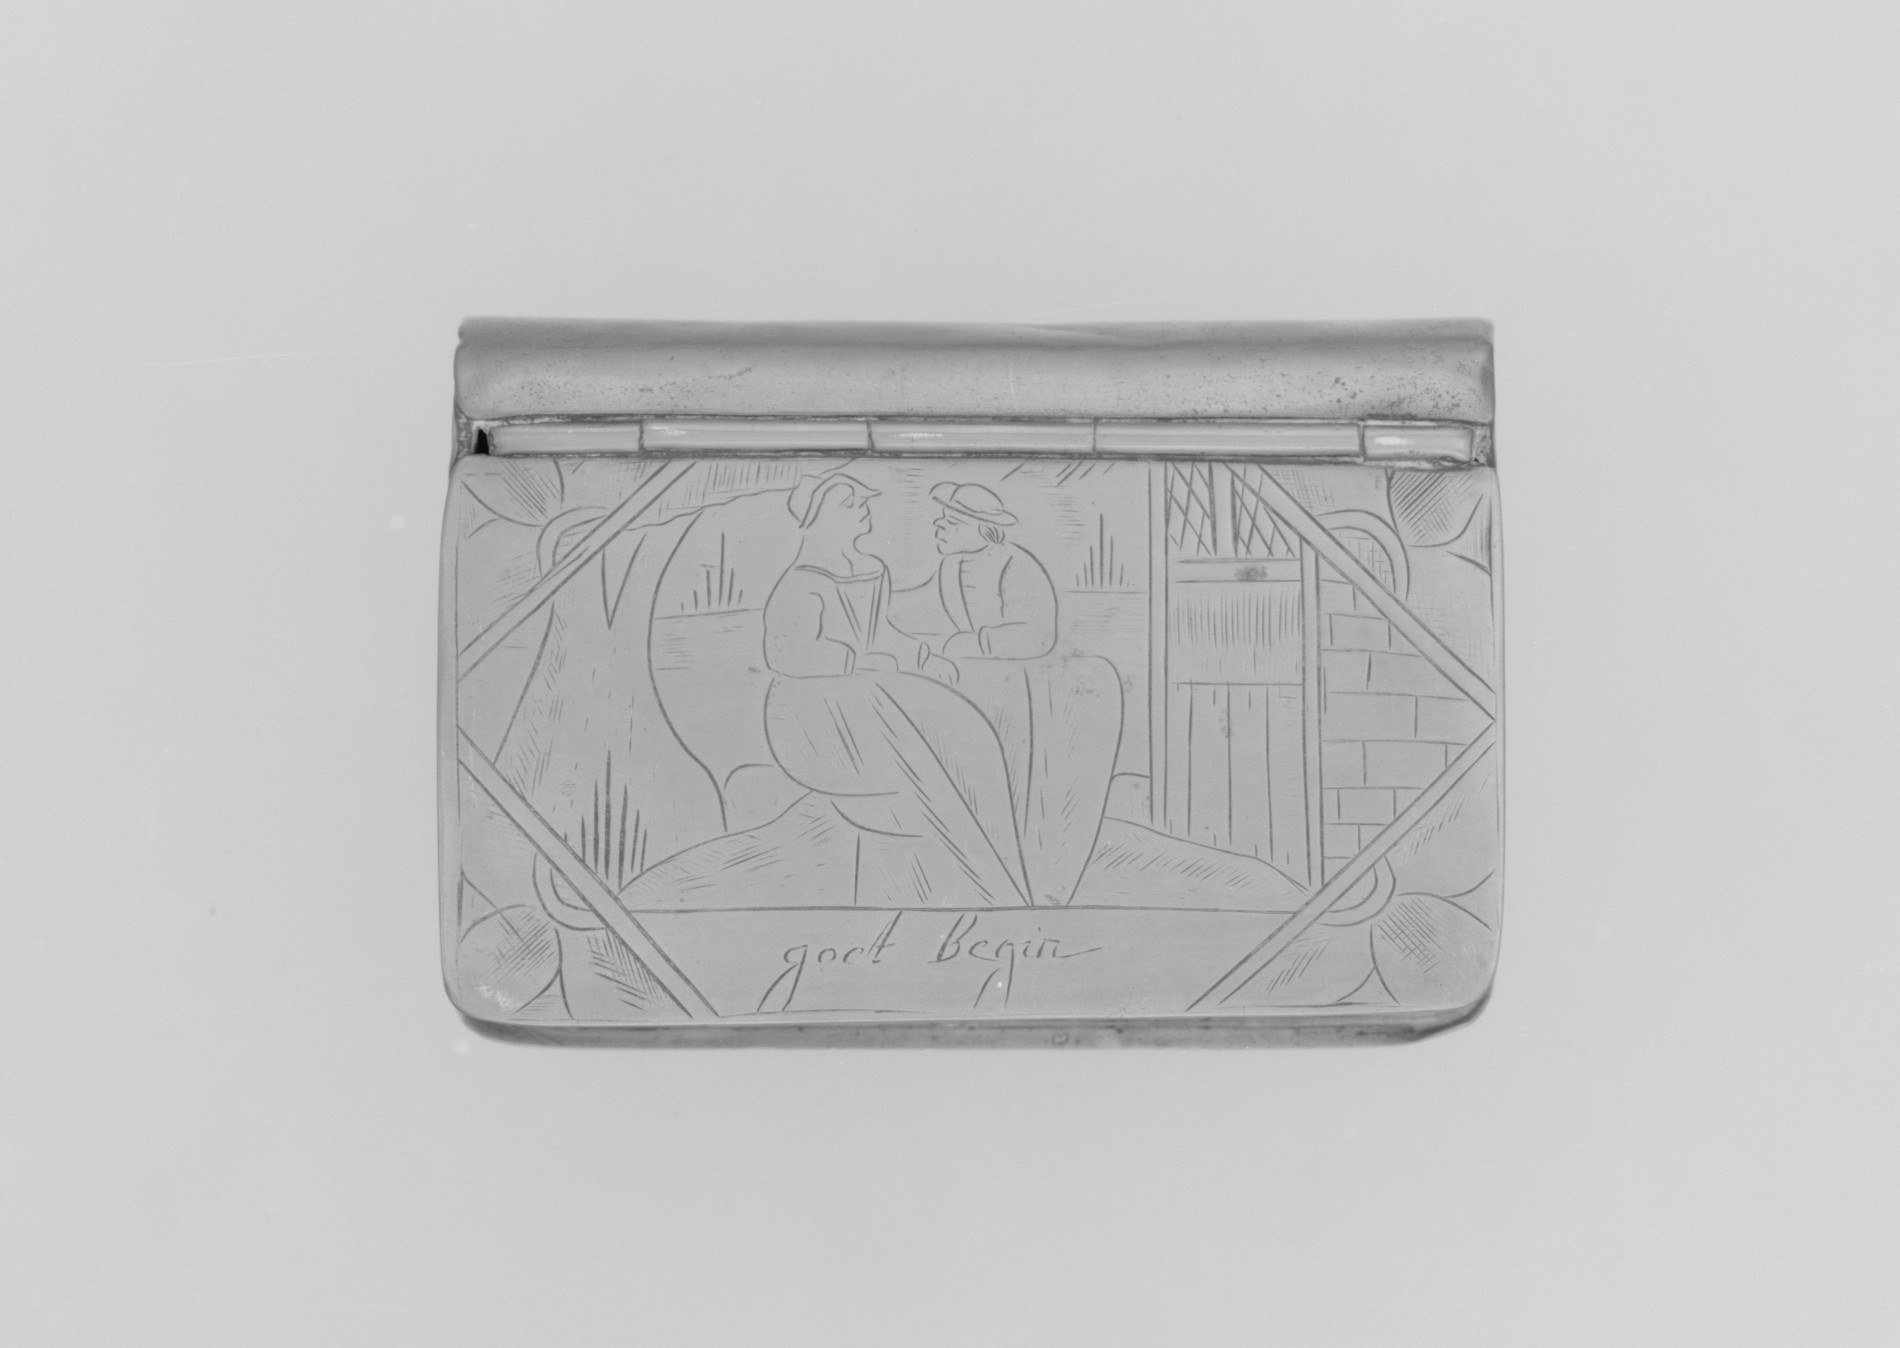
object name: tobacco box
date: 1601-1700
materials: brass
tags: couples